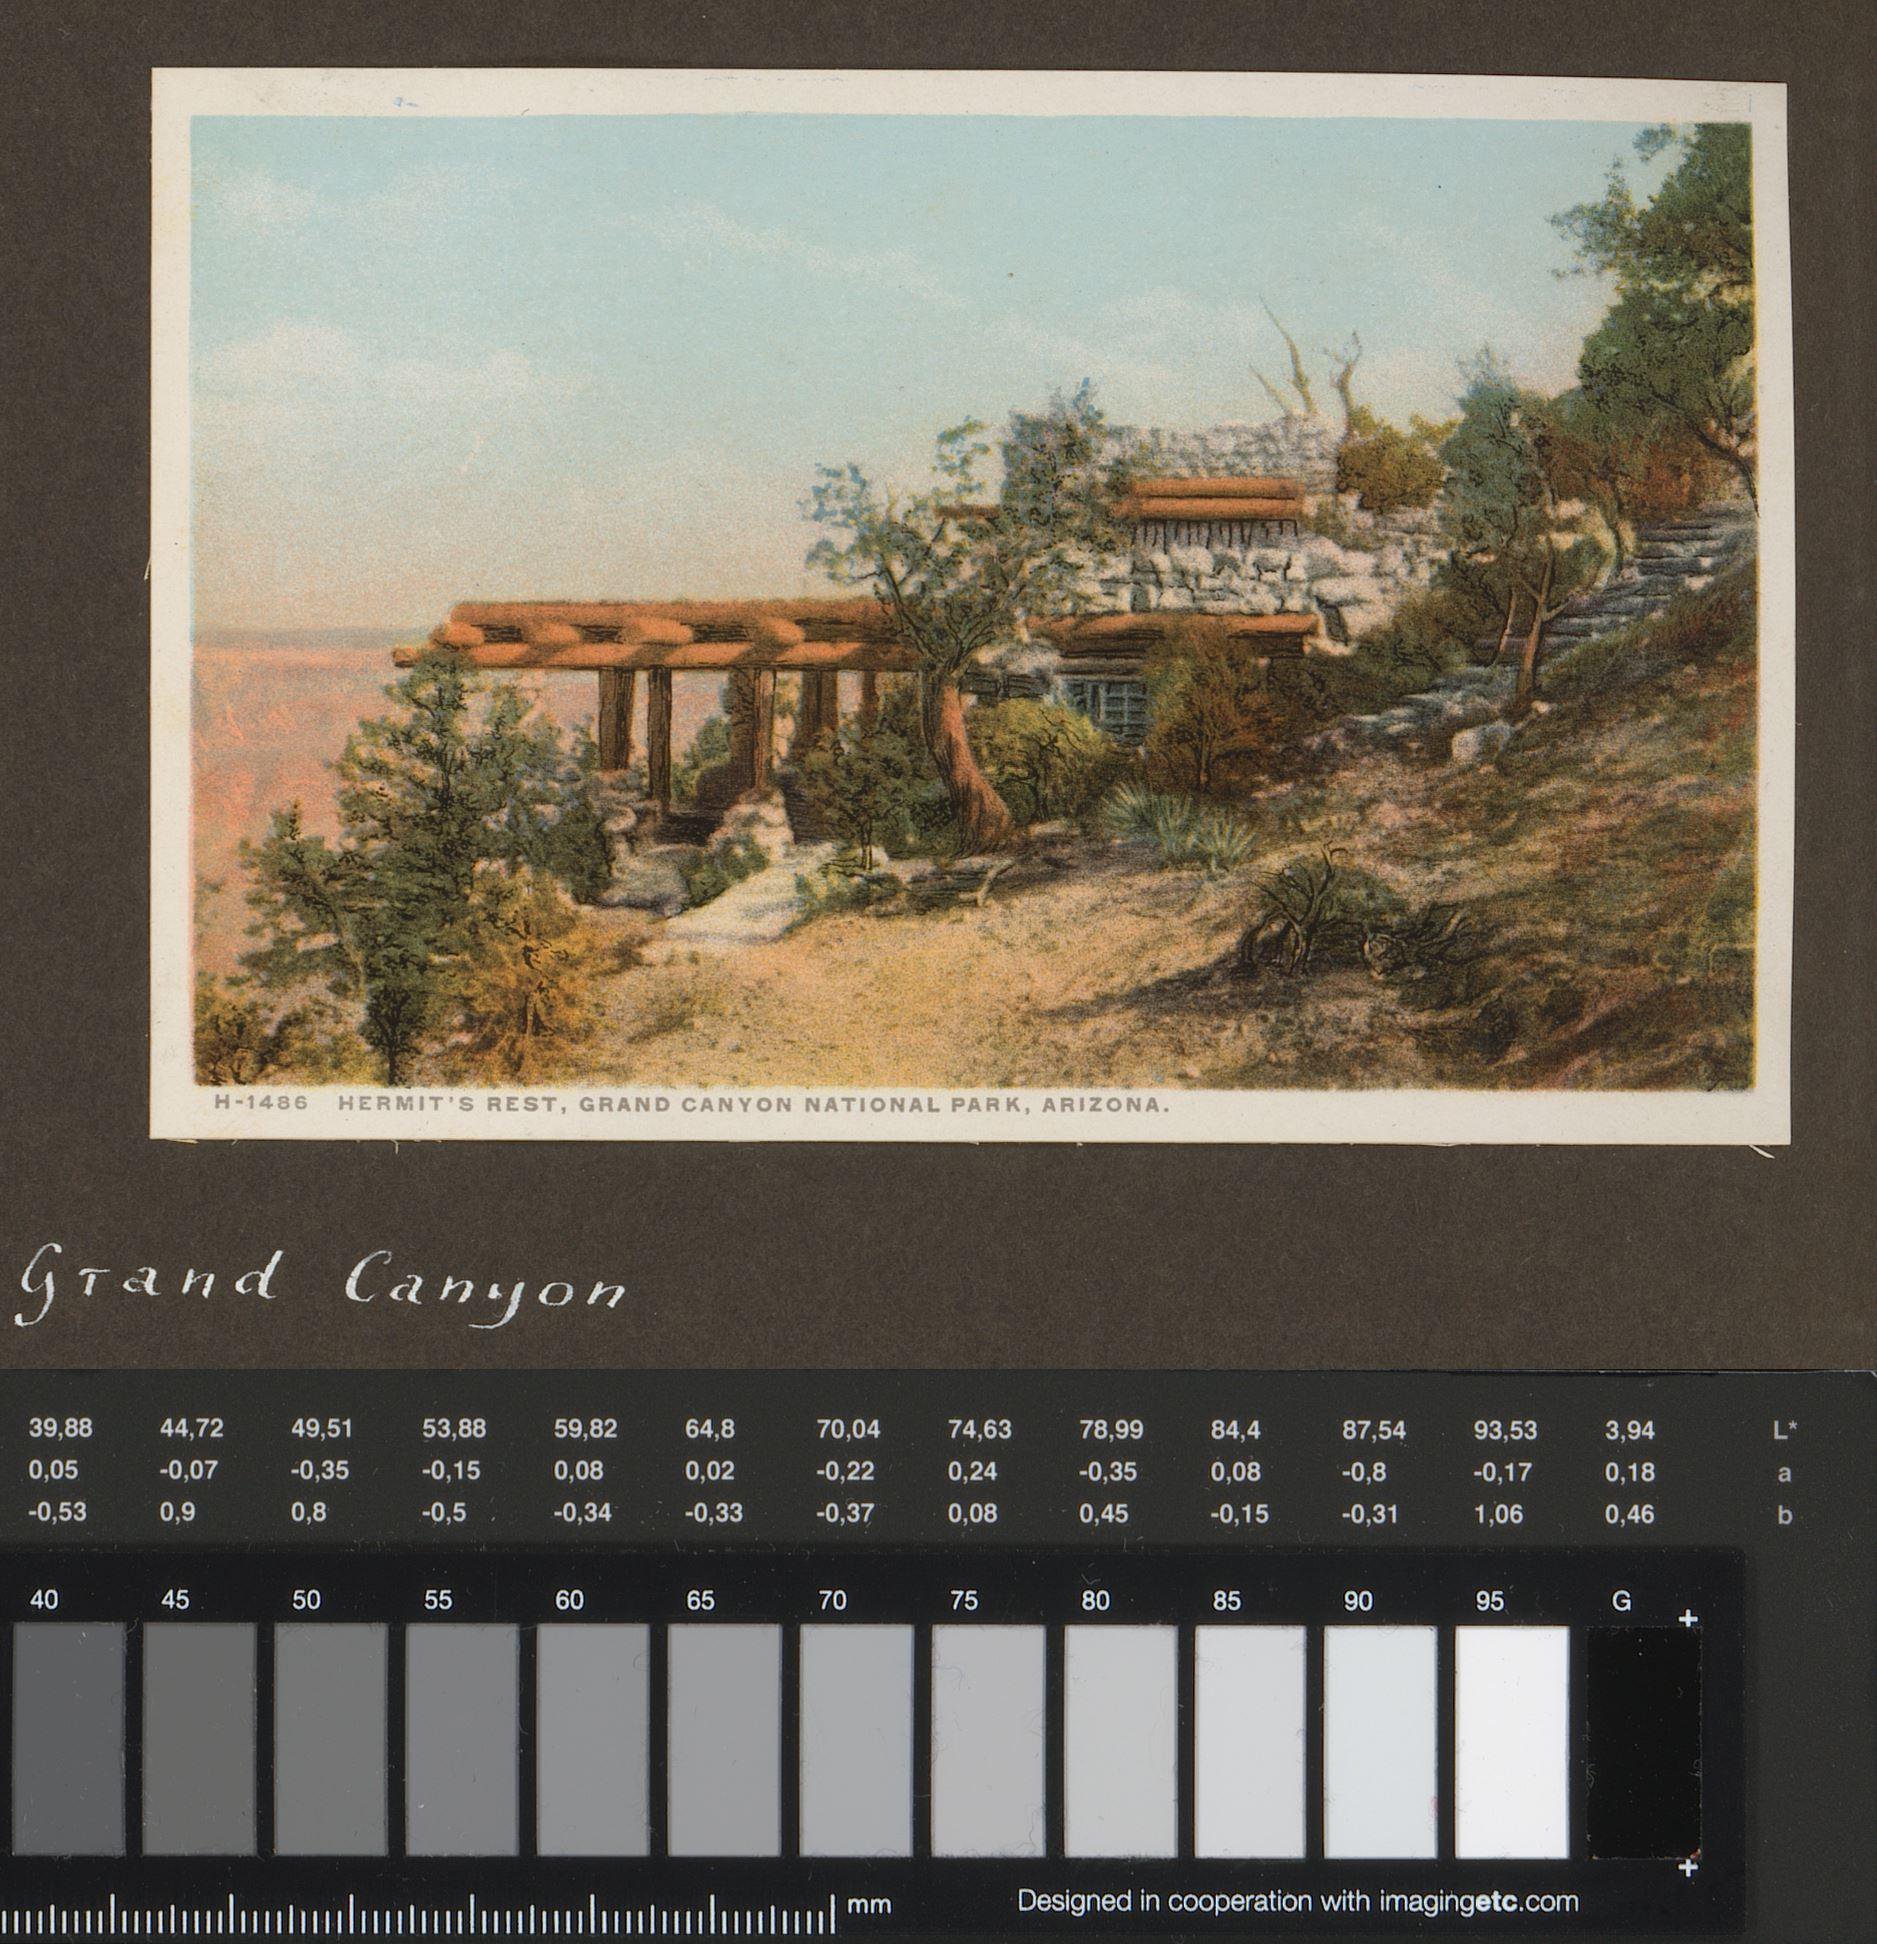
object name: photomechanical print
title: Hermit's Rest, Grand Canyon National Park, Arizona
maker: Anonymous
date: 1928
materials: paper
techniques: four-color autotype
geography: grand canyon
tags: civic architecture; edifices; dwellings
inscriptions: number: ‘H - 1486’, annotation: ‘Grand Canyon’